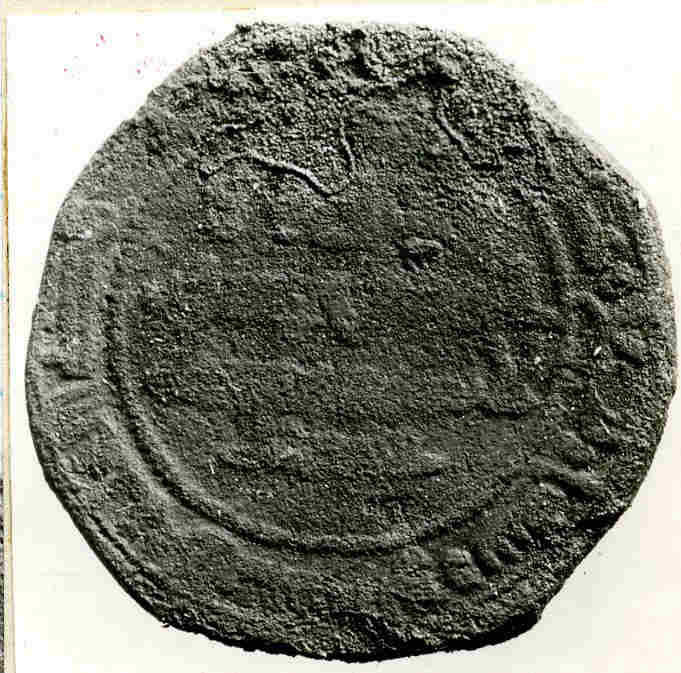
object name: coin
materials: copper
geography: iran